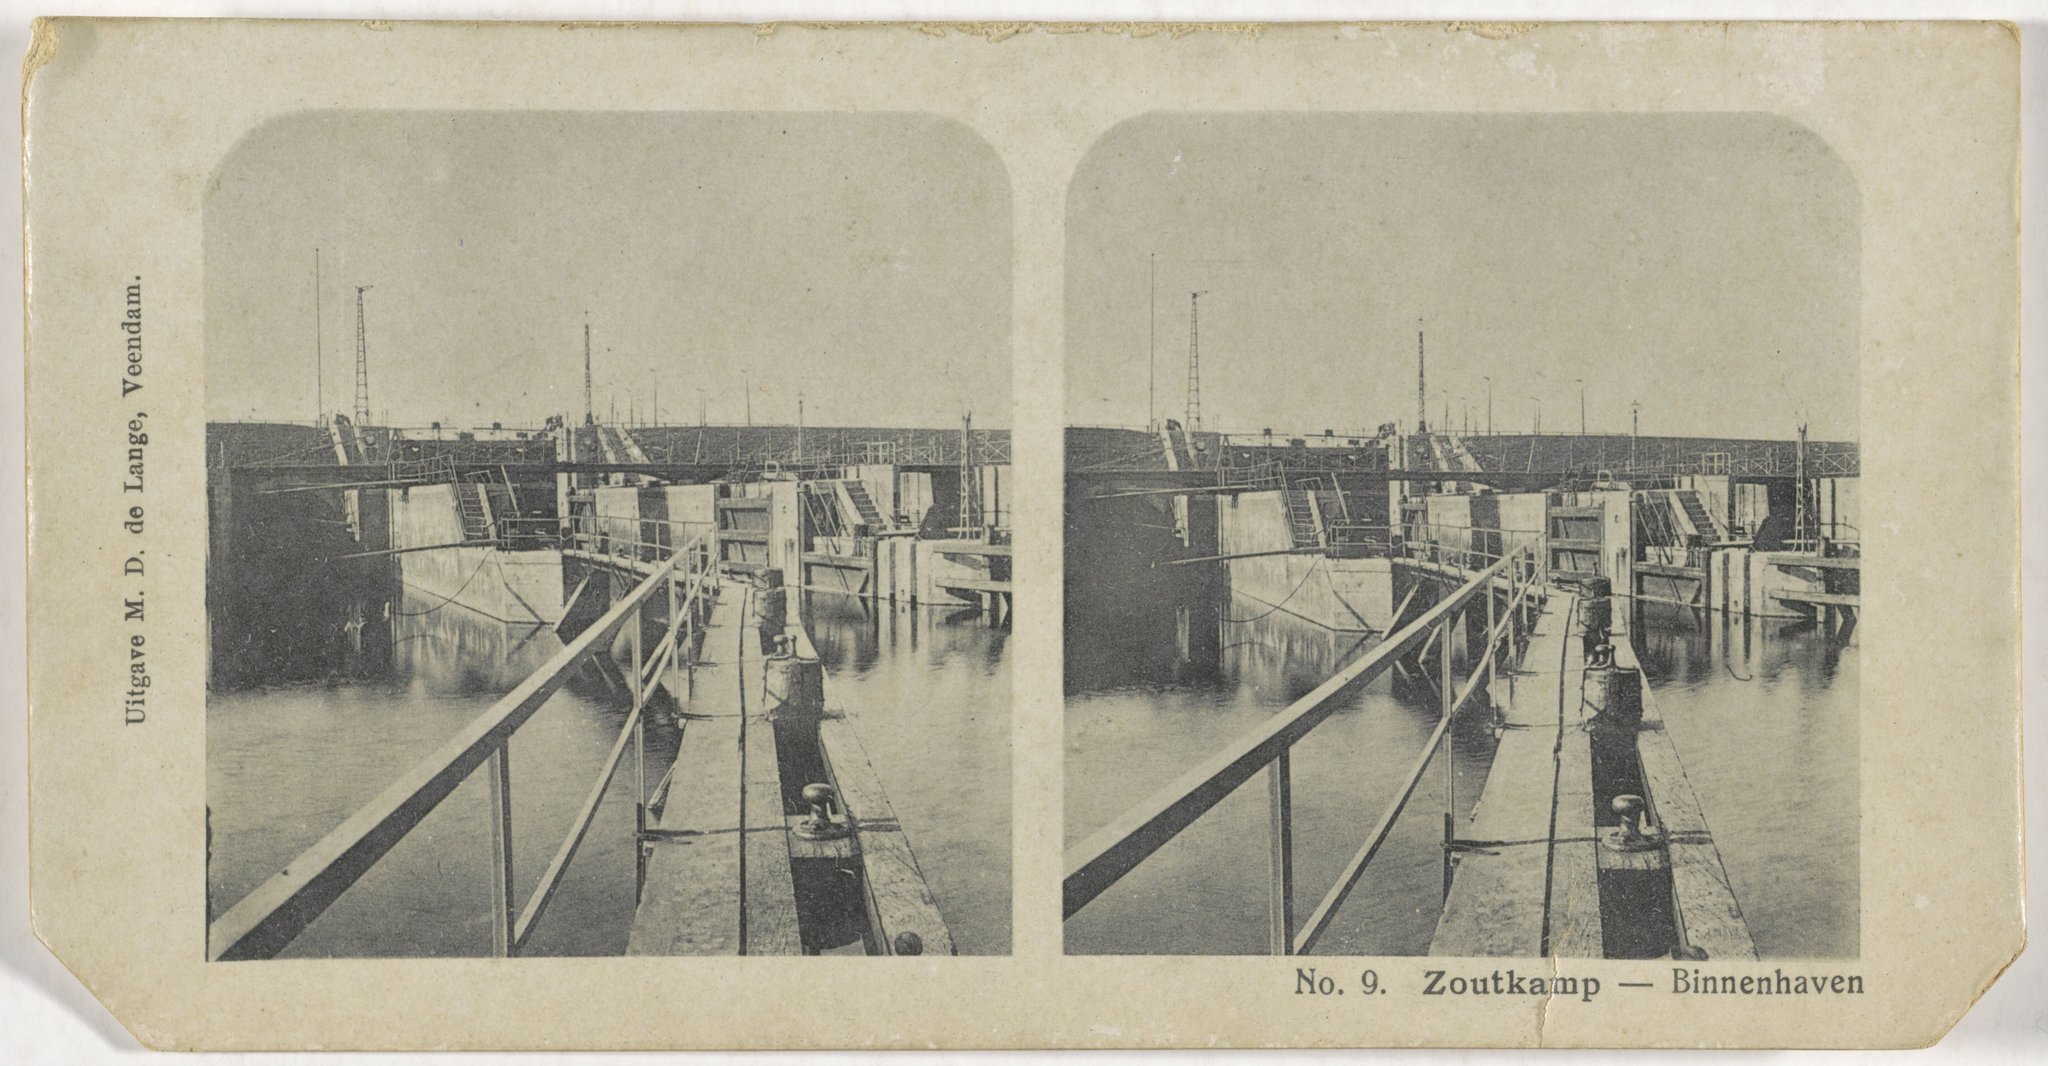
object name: photomechanical print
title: Zoutkamp - Binnenhaven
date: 1900-1911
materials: paper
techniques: photograph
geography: veendam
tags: harbour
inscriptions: number: ‘No. 9.’